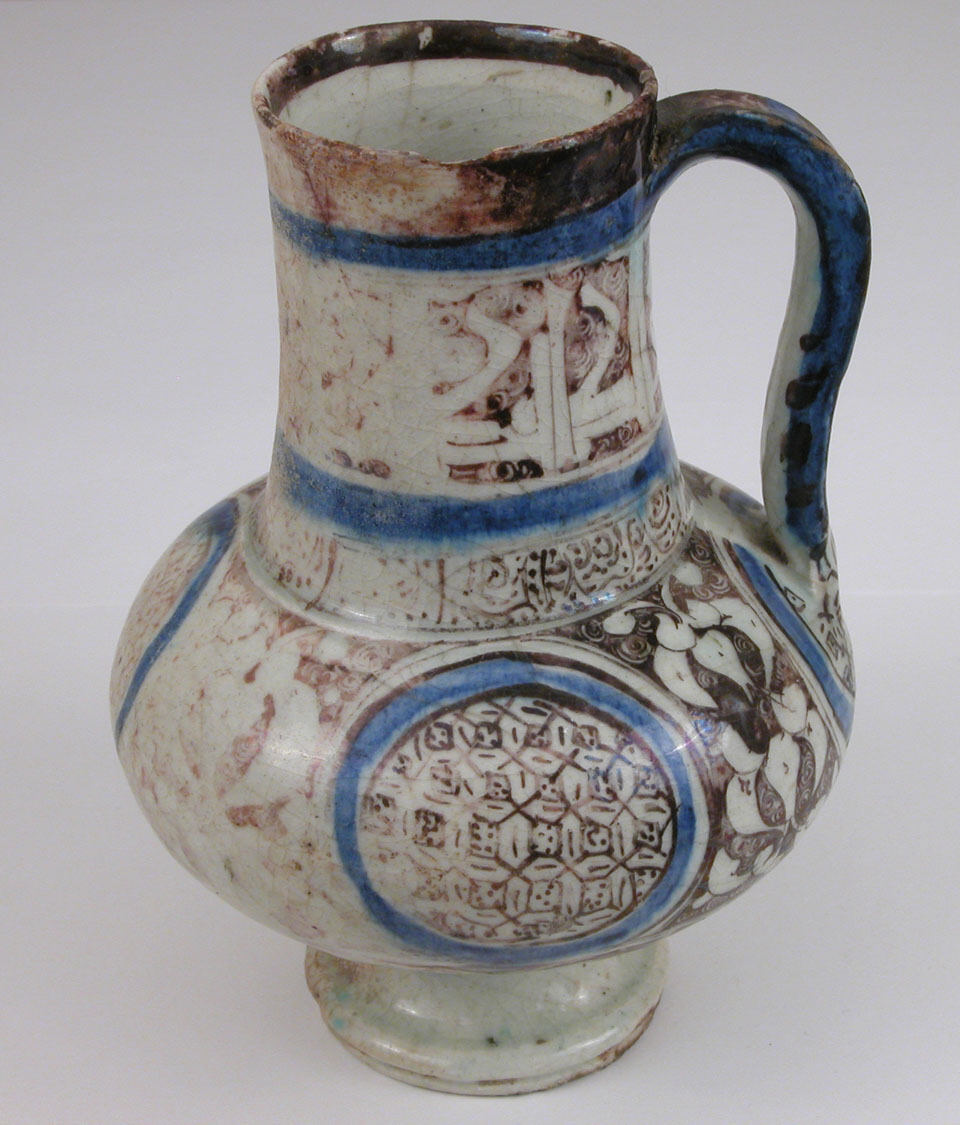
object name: ewer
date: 1101-1200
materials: glaze, stonepaste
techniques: painting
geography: syria